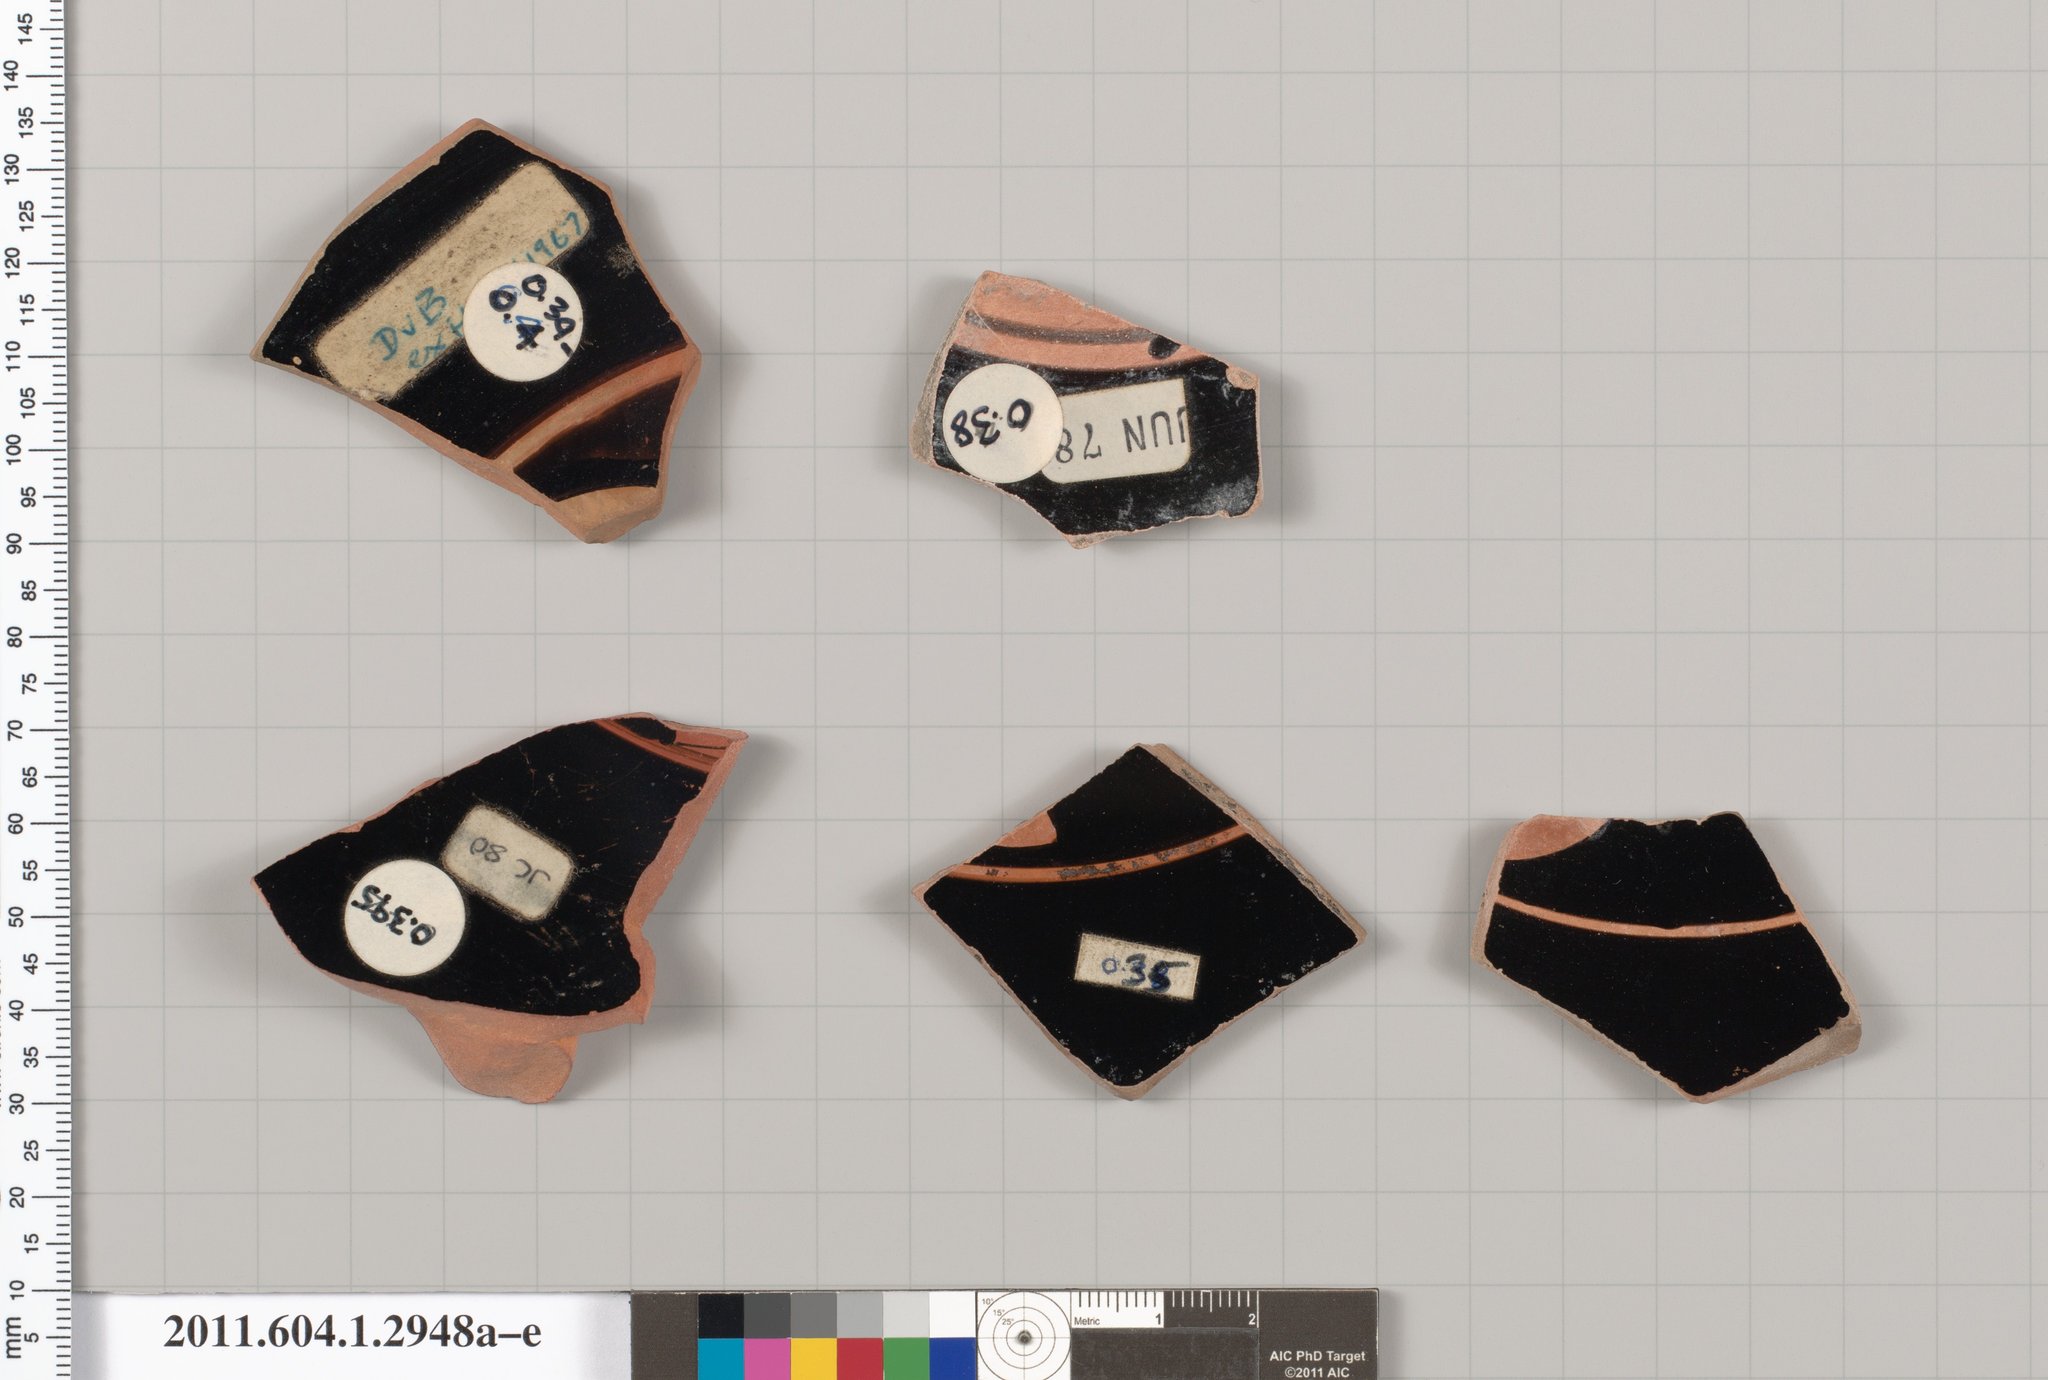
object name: kylix fragment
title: Terracotta fragments of kylikes (drinking cups)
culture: greek, attic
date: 600-401 BCE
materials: terracotta